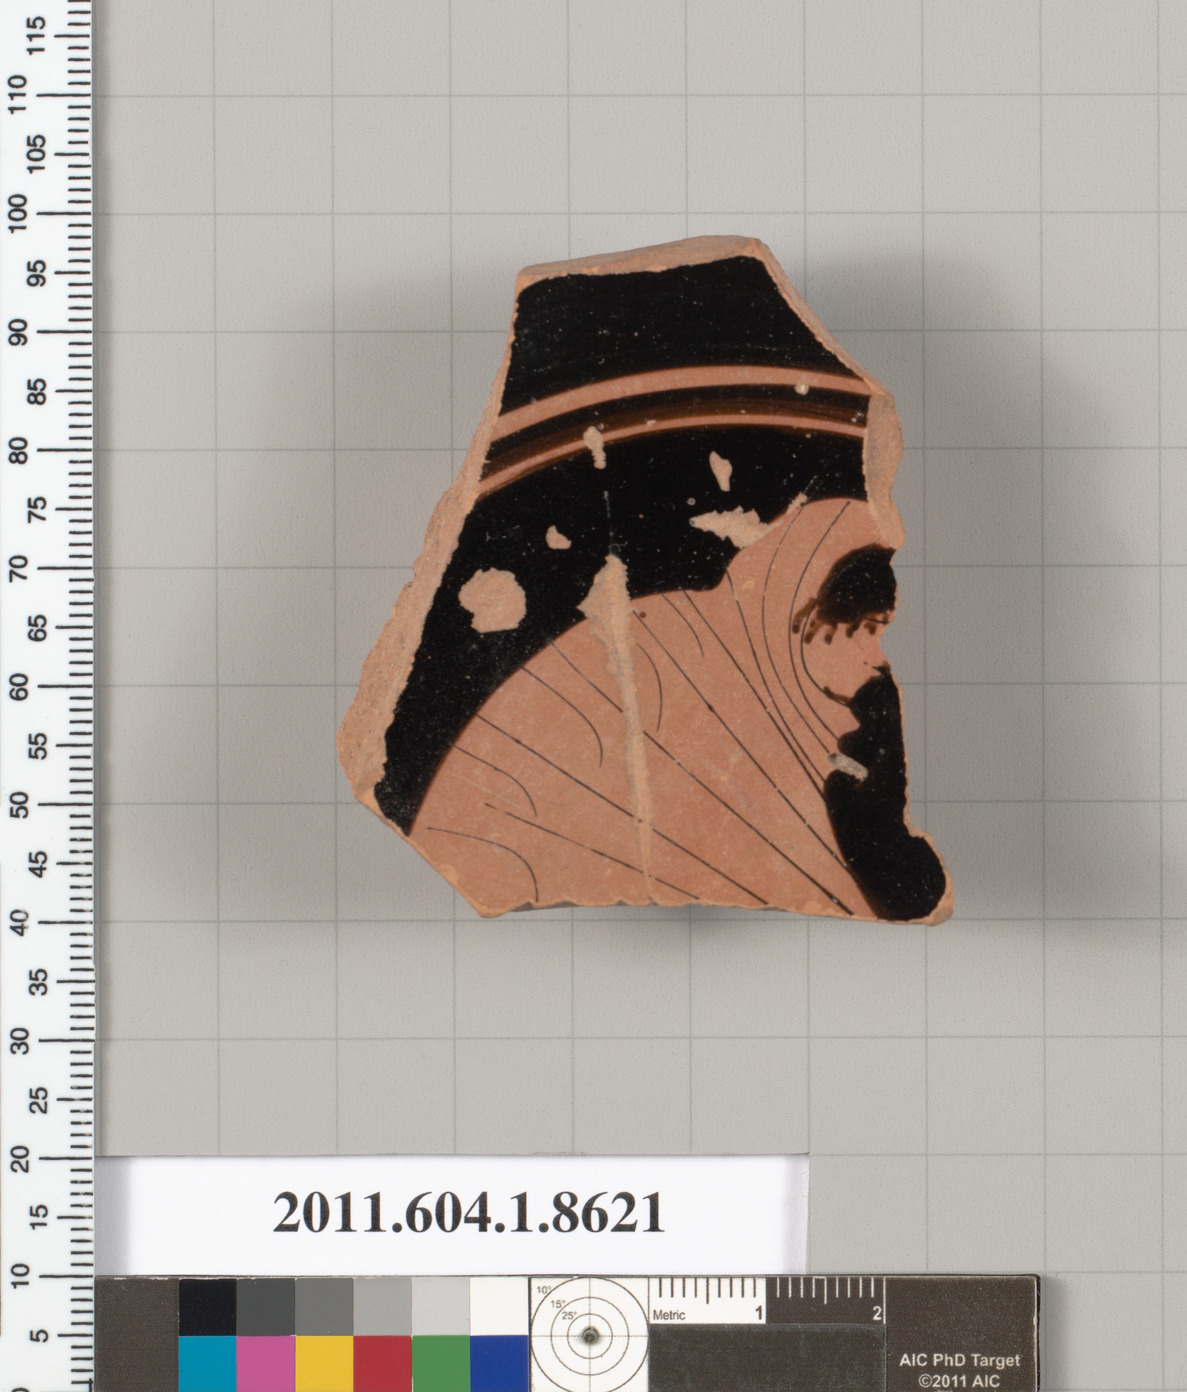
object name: kylix fragment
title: Terracotta fragment of a stemless kylix (drinking cup)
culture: greek, attic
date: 467-435 BCE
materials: terracotta